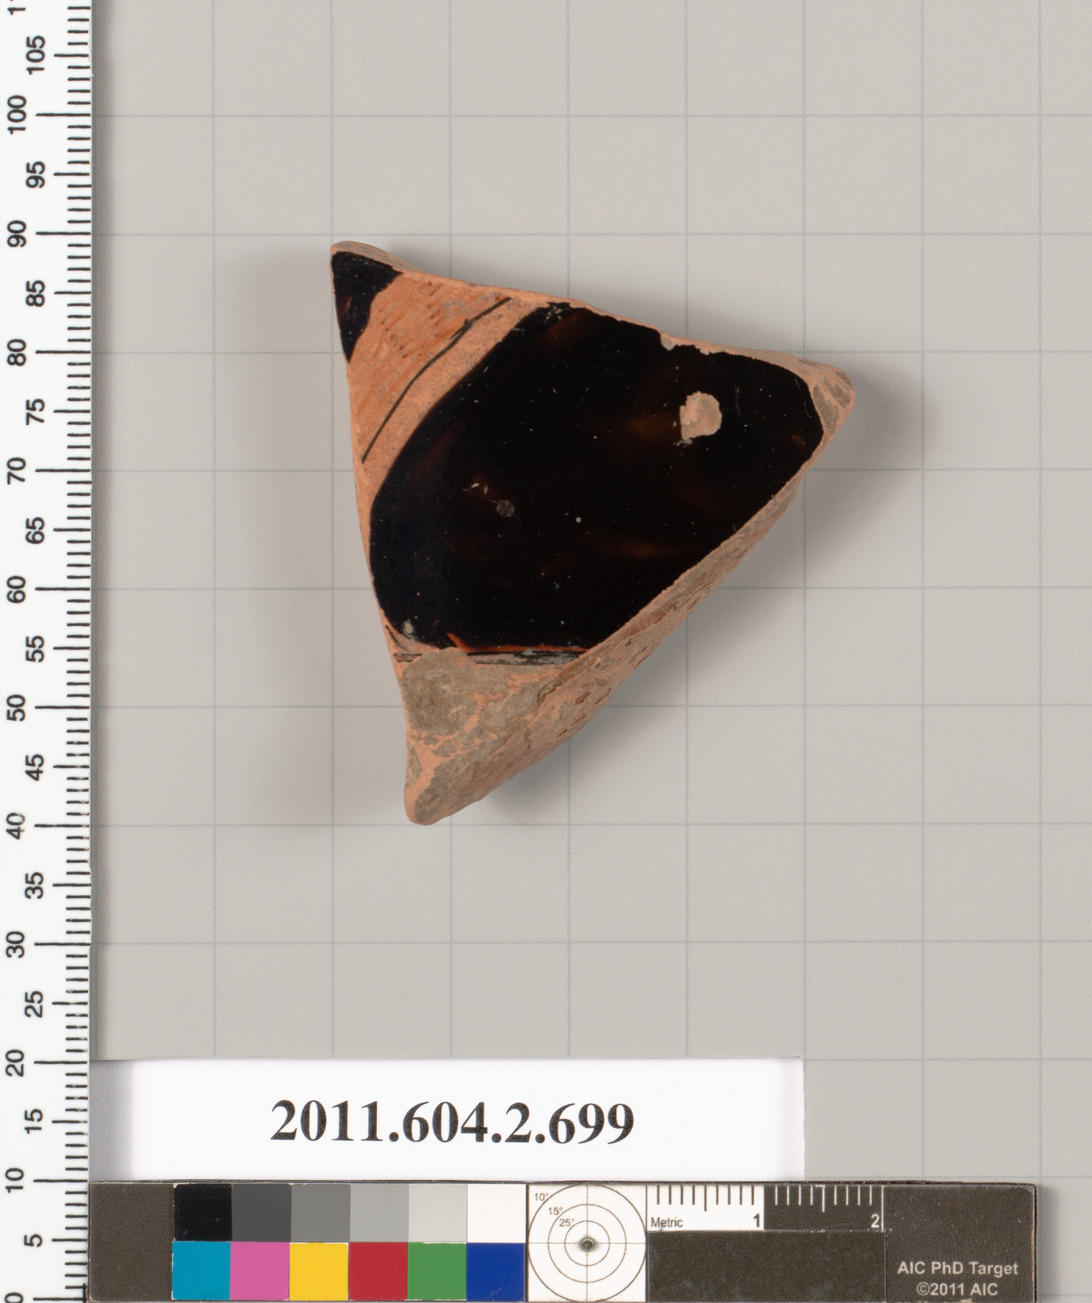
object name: calyx krater fragment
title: Terracotta fragment of a calyx-krater (bowl for mixing wine and water)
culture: greek, attic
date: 475-451 BCE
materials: terracotta